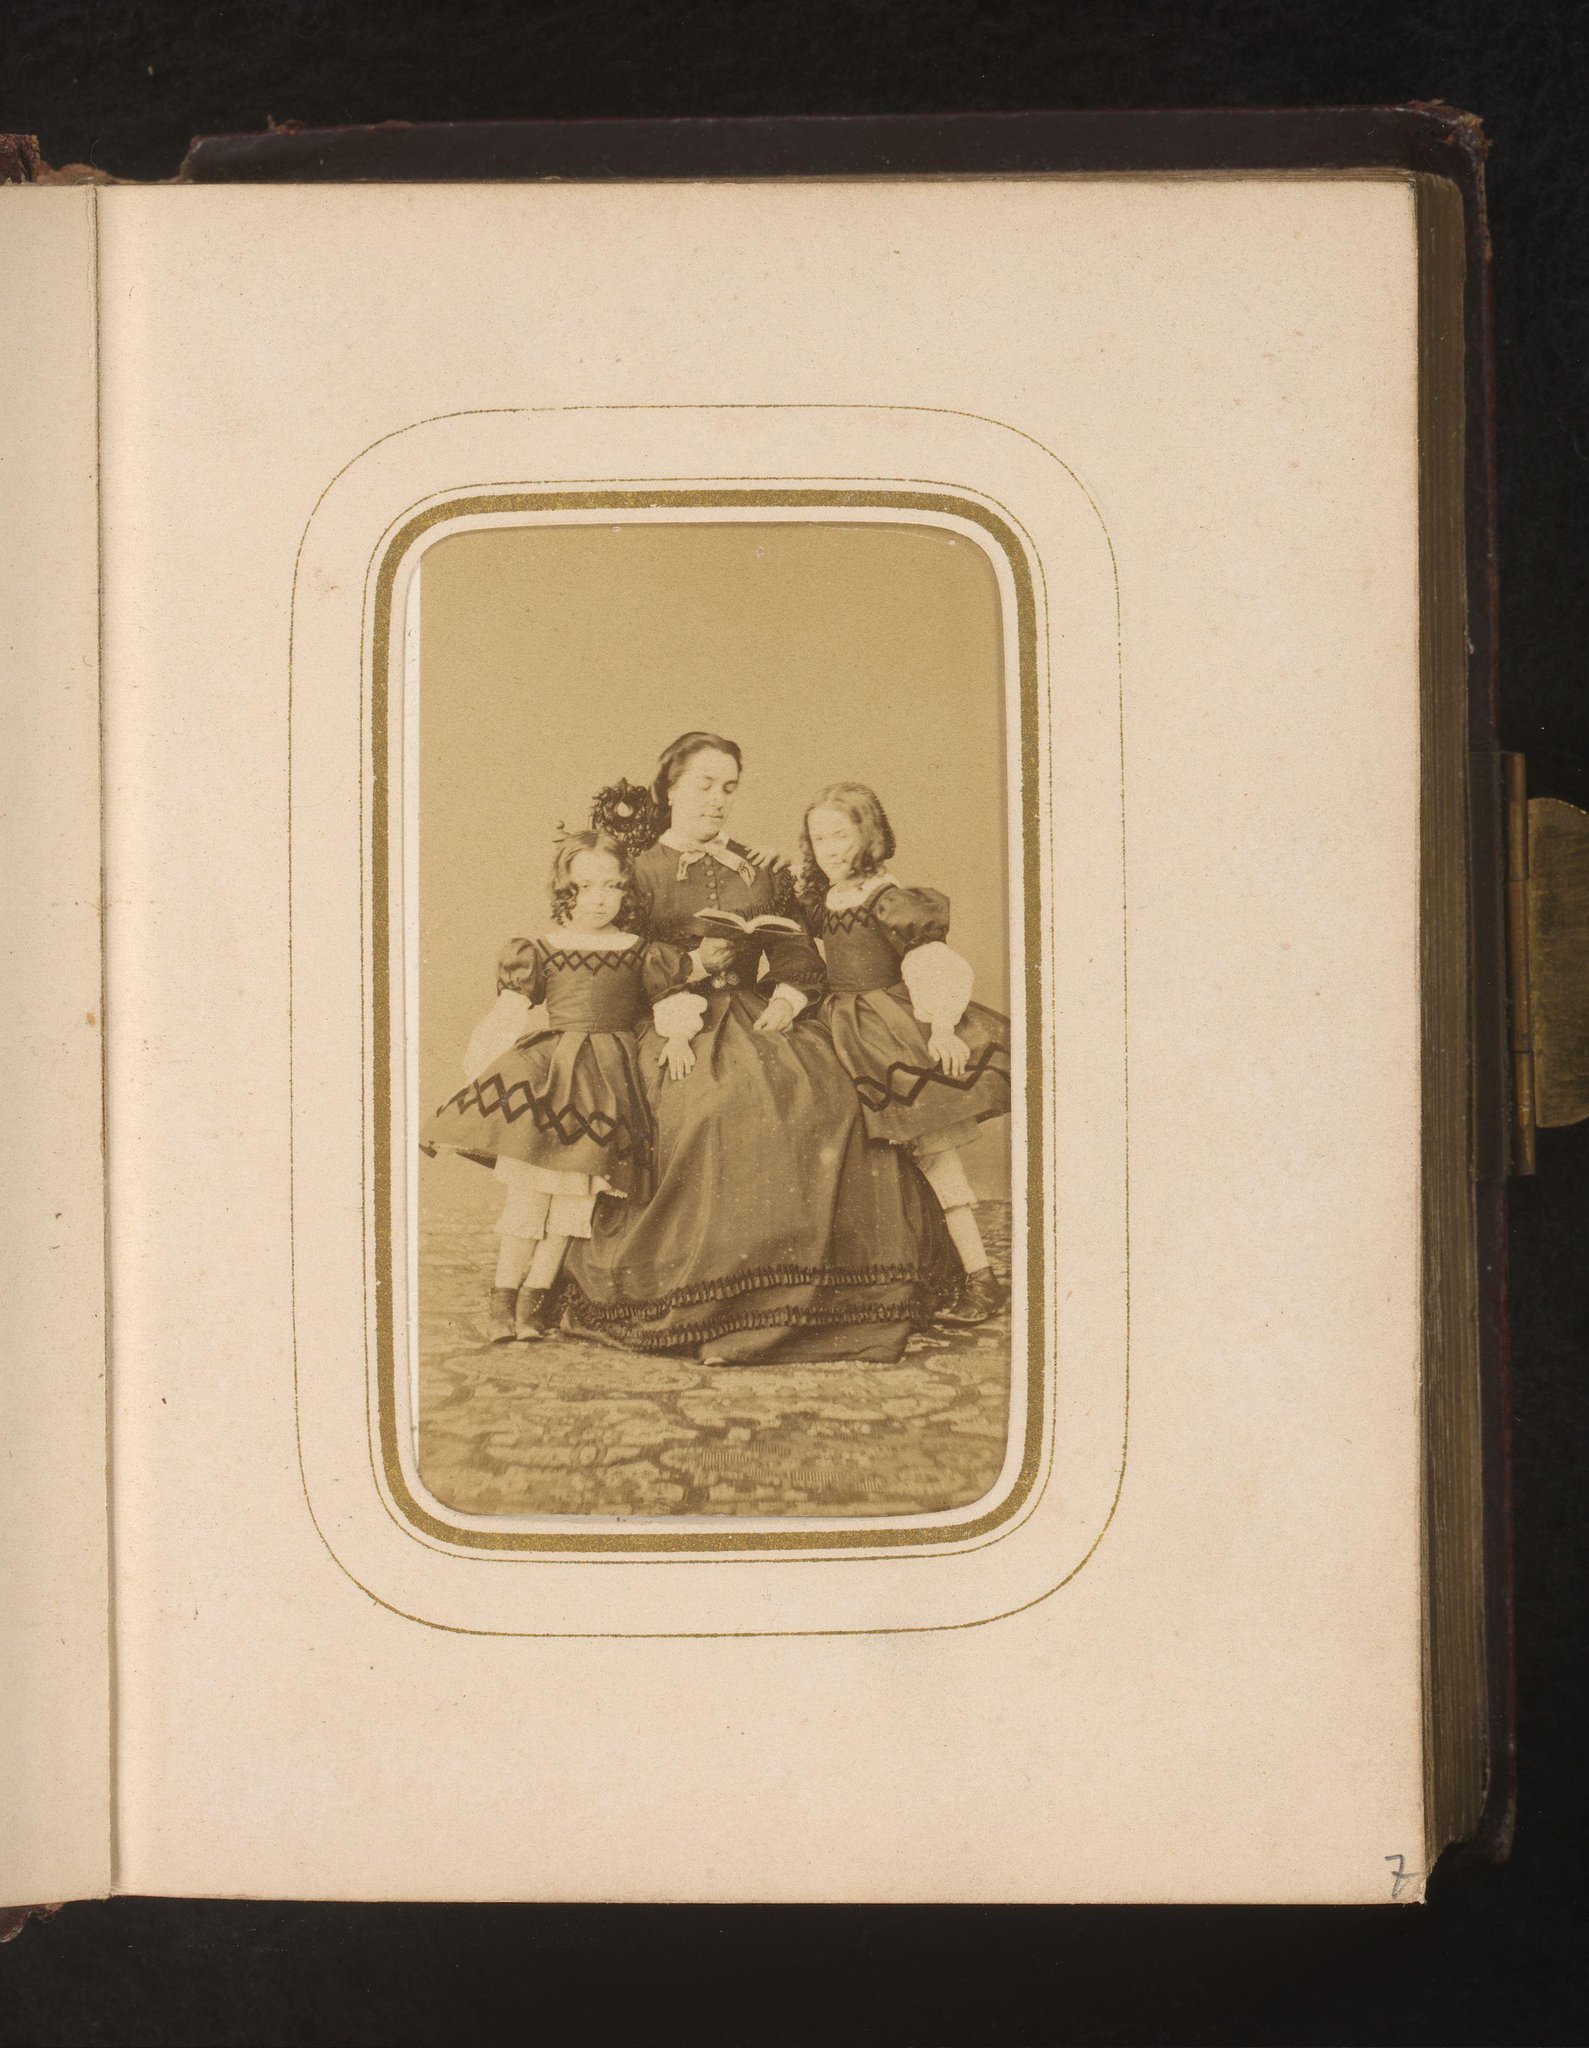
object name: album leaf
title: Portret van een zittende moeder met twee meisjes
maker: morel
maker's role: fotograaf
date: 1860-1900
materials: cardboard, photographic support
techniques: albumen print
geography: paris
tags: girl (child between toddler and youth), mother and baby or young child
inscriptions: inscription: ‘Morel/ Photographe/ Elève de Disdéri/ Boult Militaire, No2, Port Neuilly’